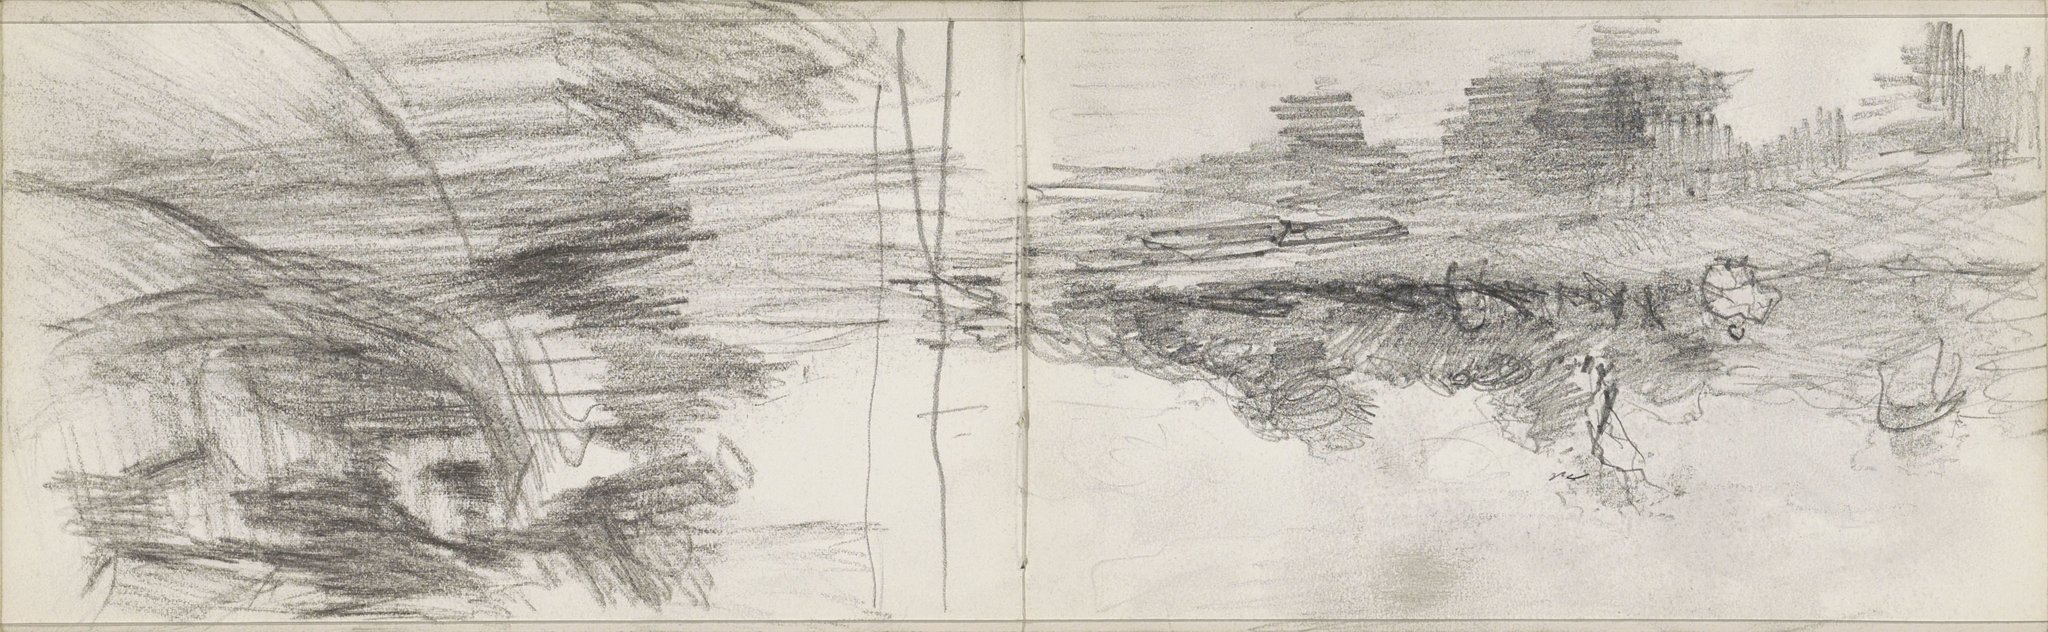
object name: sketchbook leaf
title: Landschap met bomen en een zittende figuur aan een waterkant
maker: anton mauve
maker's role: draughtsman, painter, print maker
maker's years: 1838-1888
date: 1848-1888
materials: chalk, paper, pencil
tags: landscapes with waters, waterscapes, seascapes (in the temperate zone) (+ landscape with figures, staffage)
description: Blad 10 verso en 11 recto uit een schetsboek met 43 bladen.